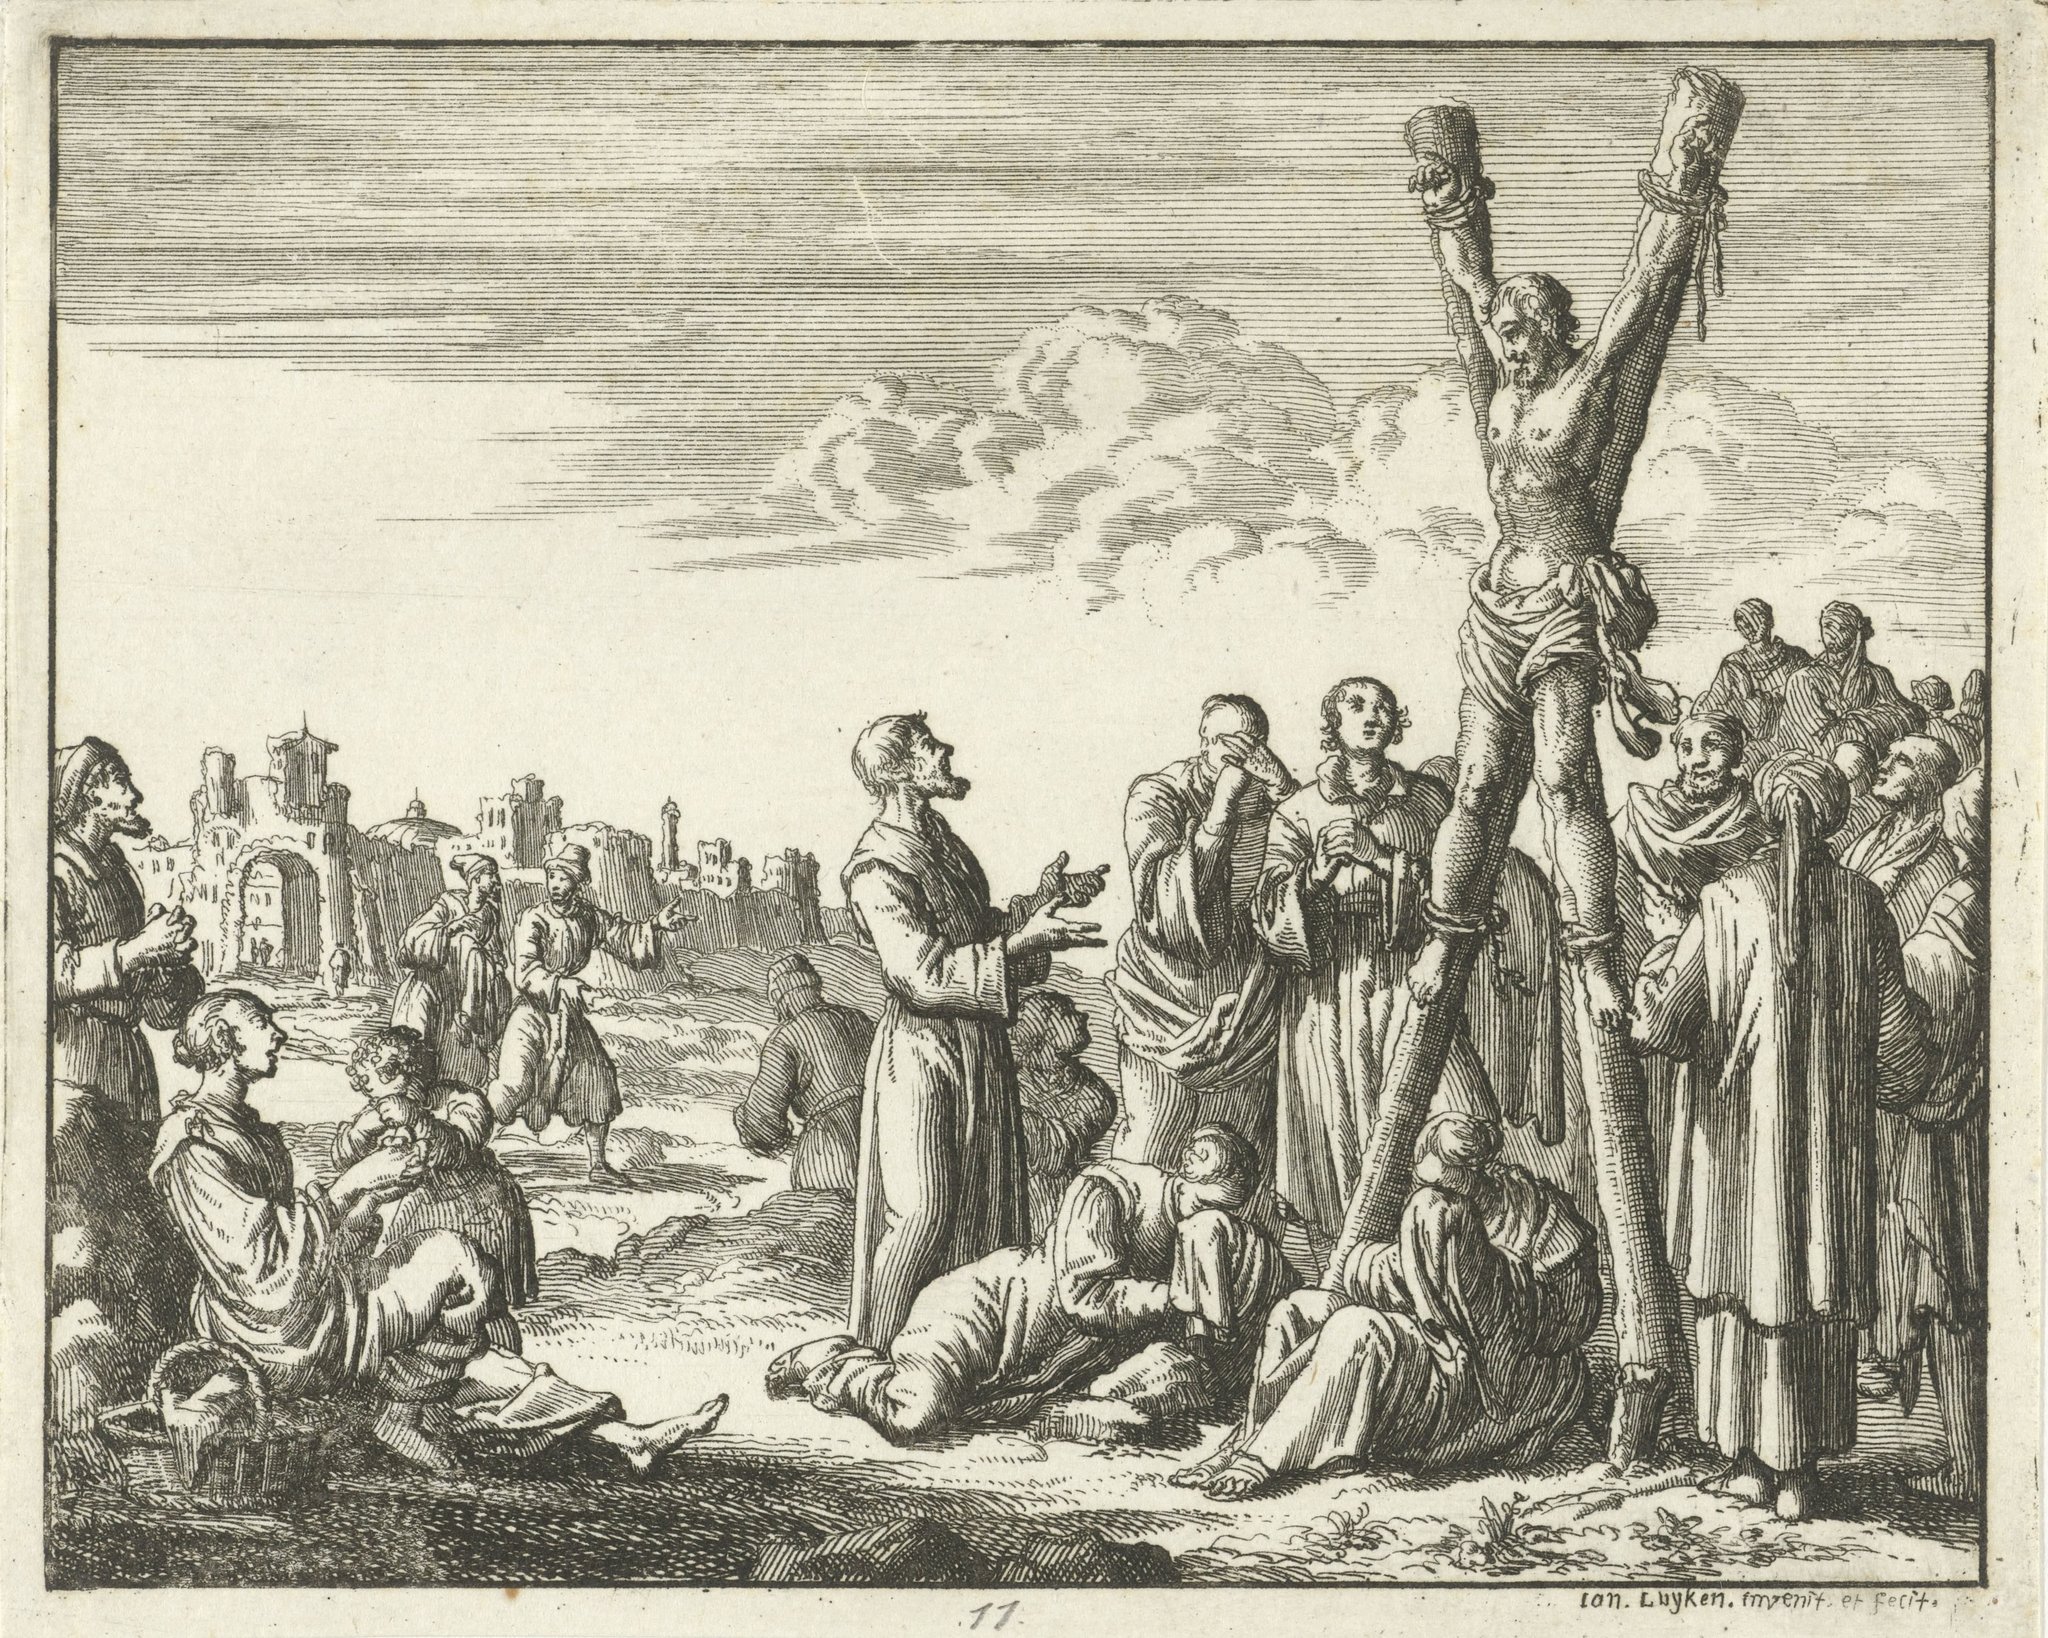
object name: print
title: Marteldood van Andreas aan het kruis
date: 1685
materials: paper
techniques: etching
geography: amsterdam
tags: crucifixion of andrew: he is undressed and tied to the cross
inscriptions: number: ‘11’, collector's mark: Lugt 2228